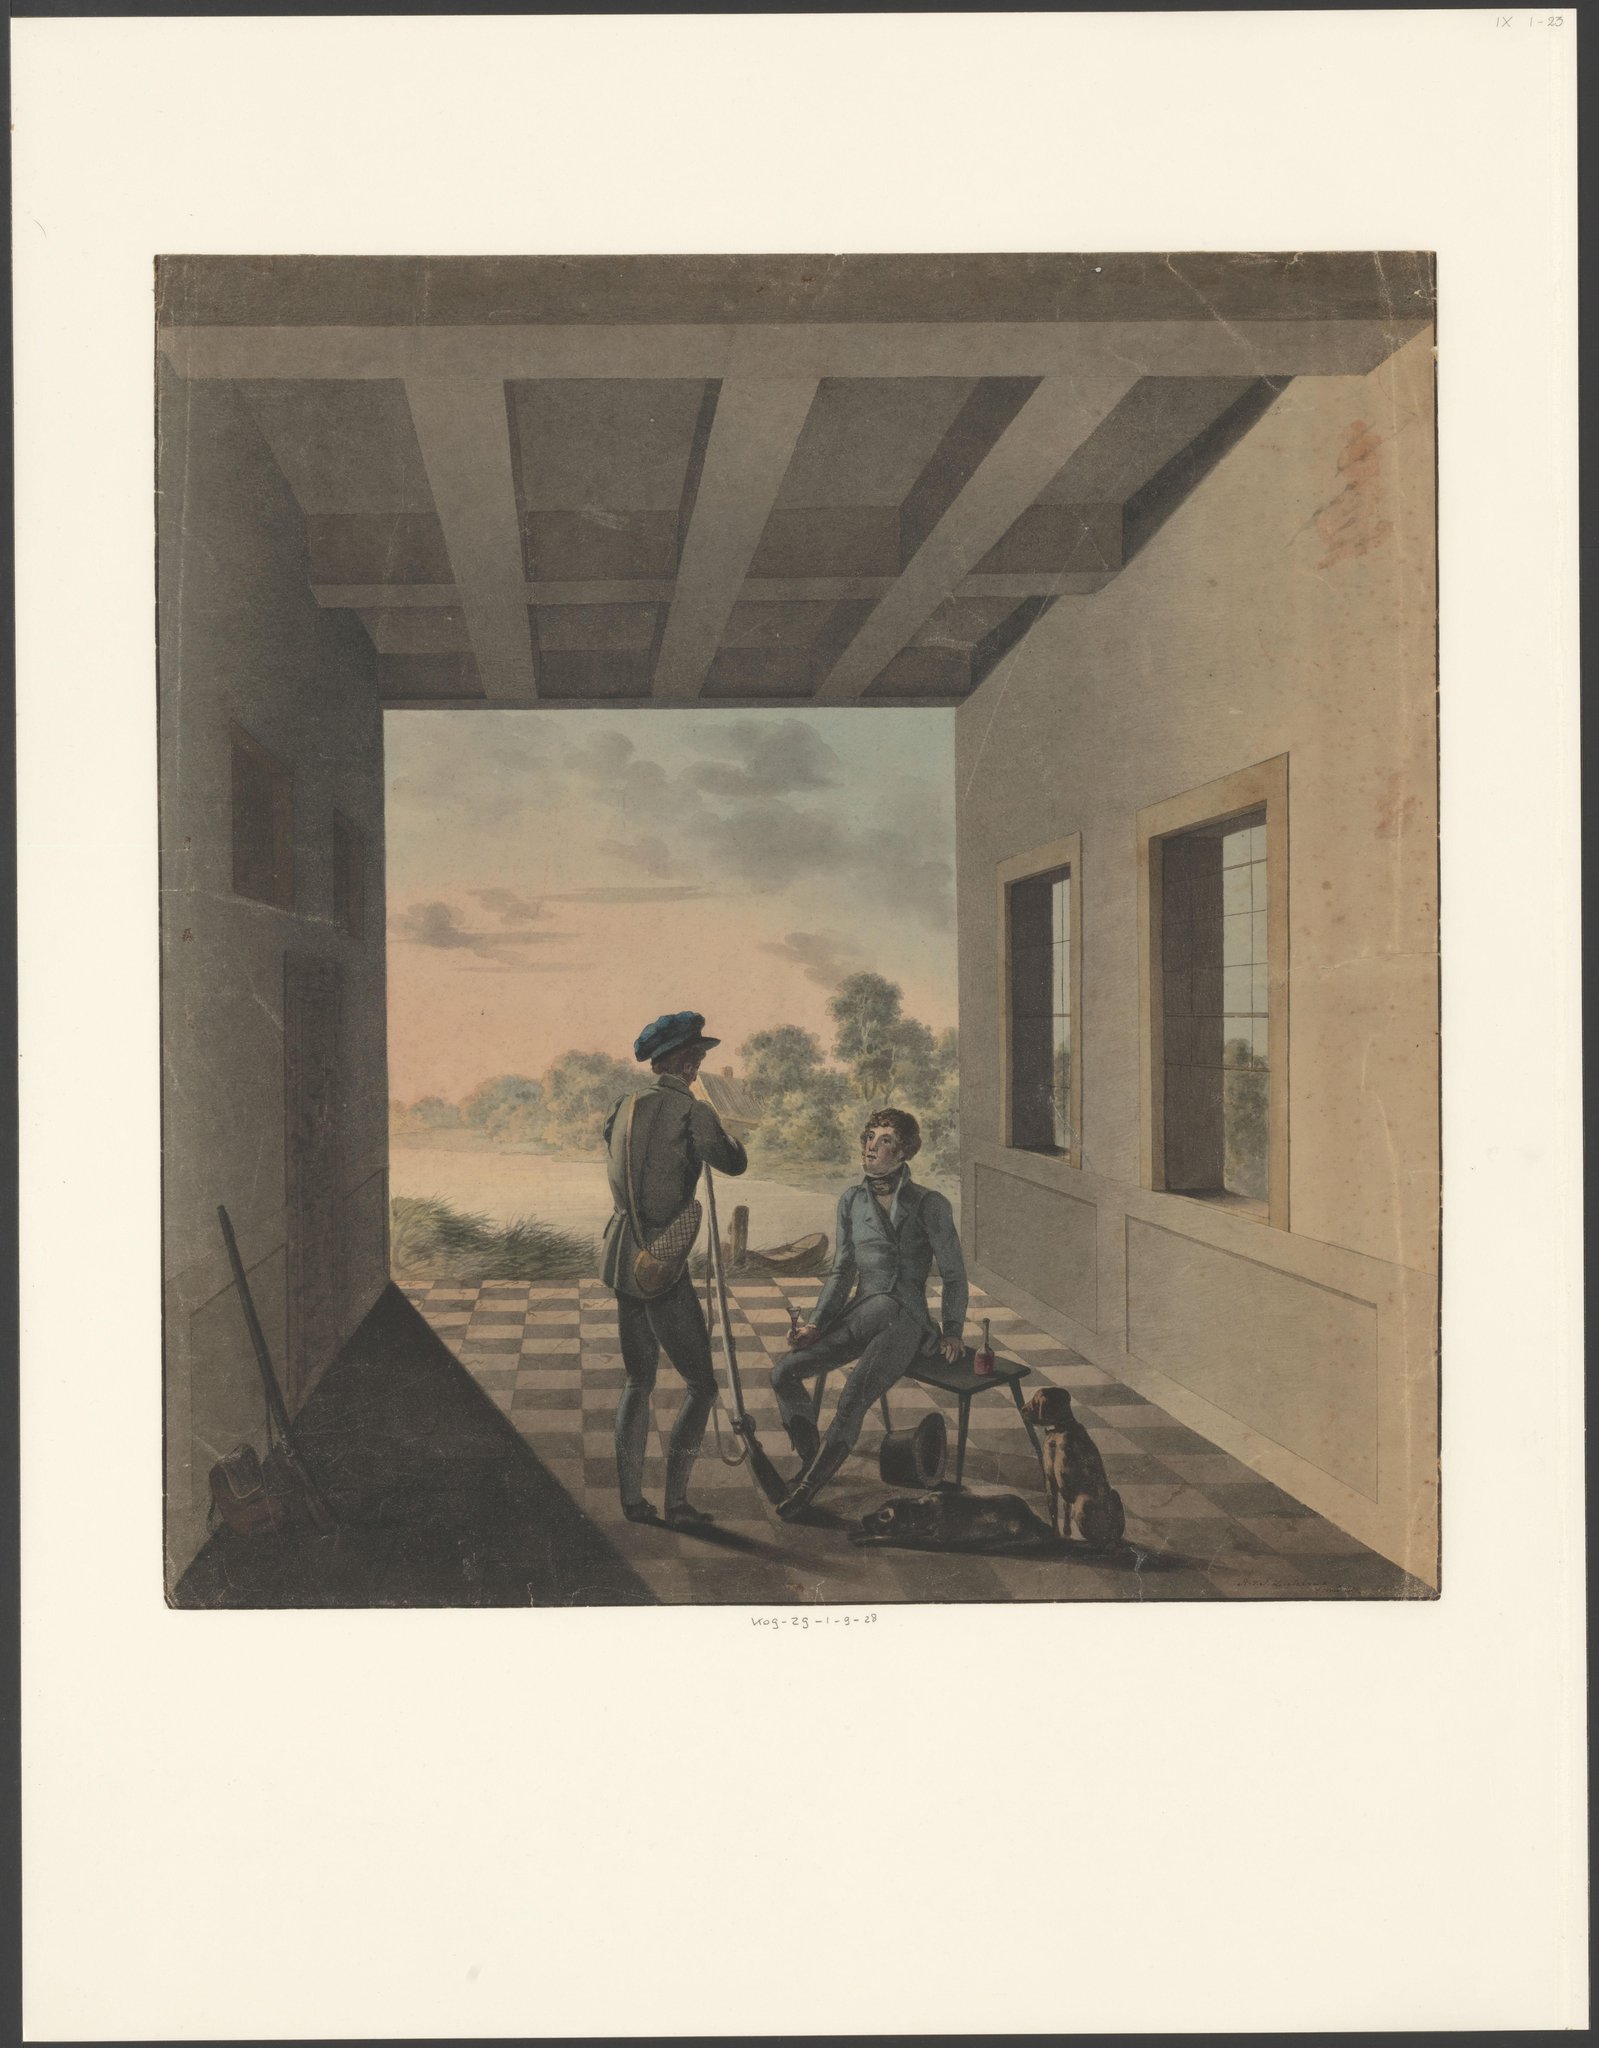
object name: drawing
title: Twee mannen drinken wijn in een jagershuis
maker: Anonymous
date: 1820-1829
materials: paper, watercolor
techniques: brush, pen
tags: hunter, glass of wine, sitting on an elevation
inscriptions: signature: ‘A.v.S.L. Salredo 4 mai 182(5?)’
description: Twee mannen drinken wijn in een jagershuis. Een staande man leunt op zijn geweer. De andere man zit op een bank met een glas wijn in zijn hand. Naast hem op de bank staat een fles. Bij de bank zitten twee honden. Onderwerpsrubrieken binnen de Atlas Zeden en Gewoonten: Handel, nijverheid en verkeer, jacht.